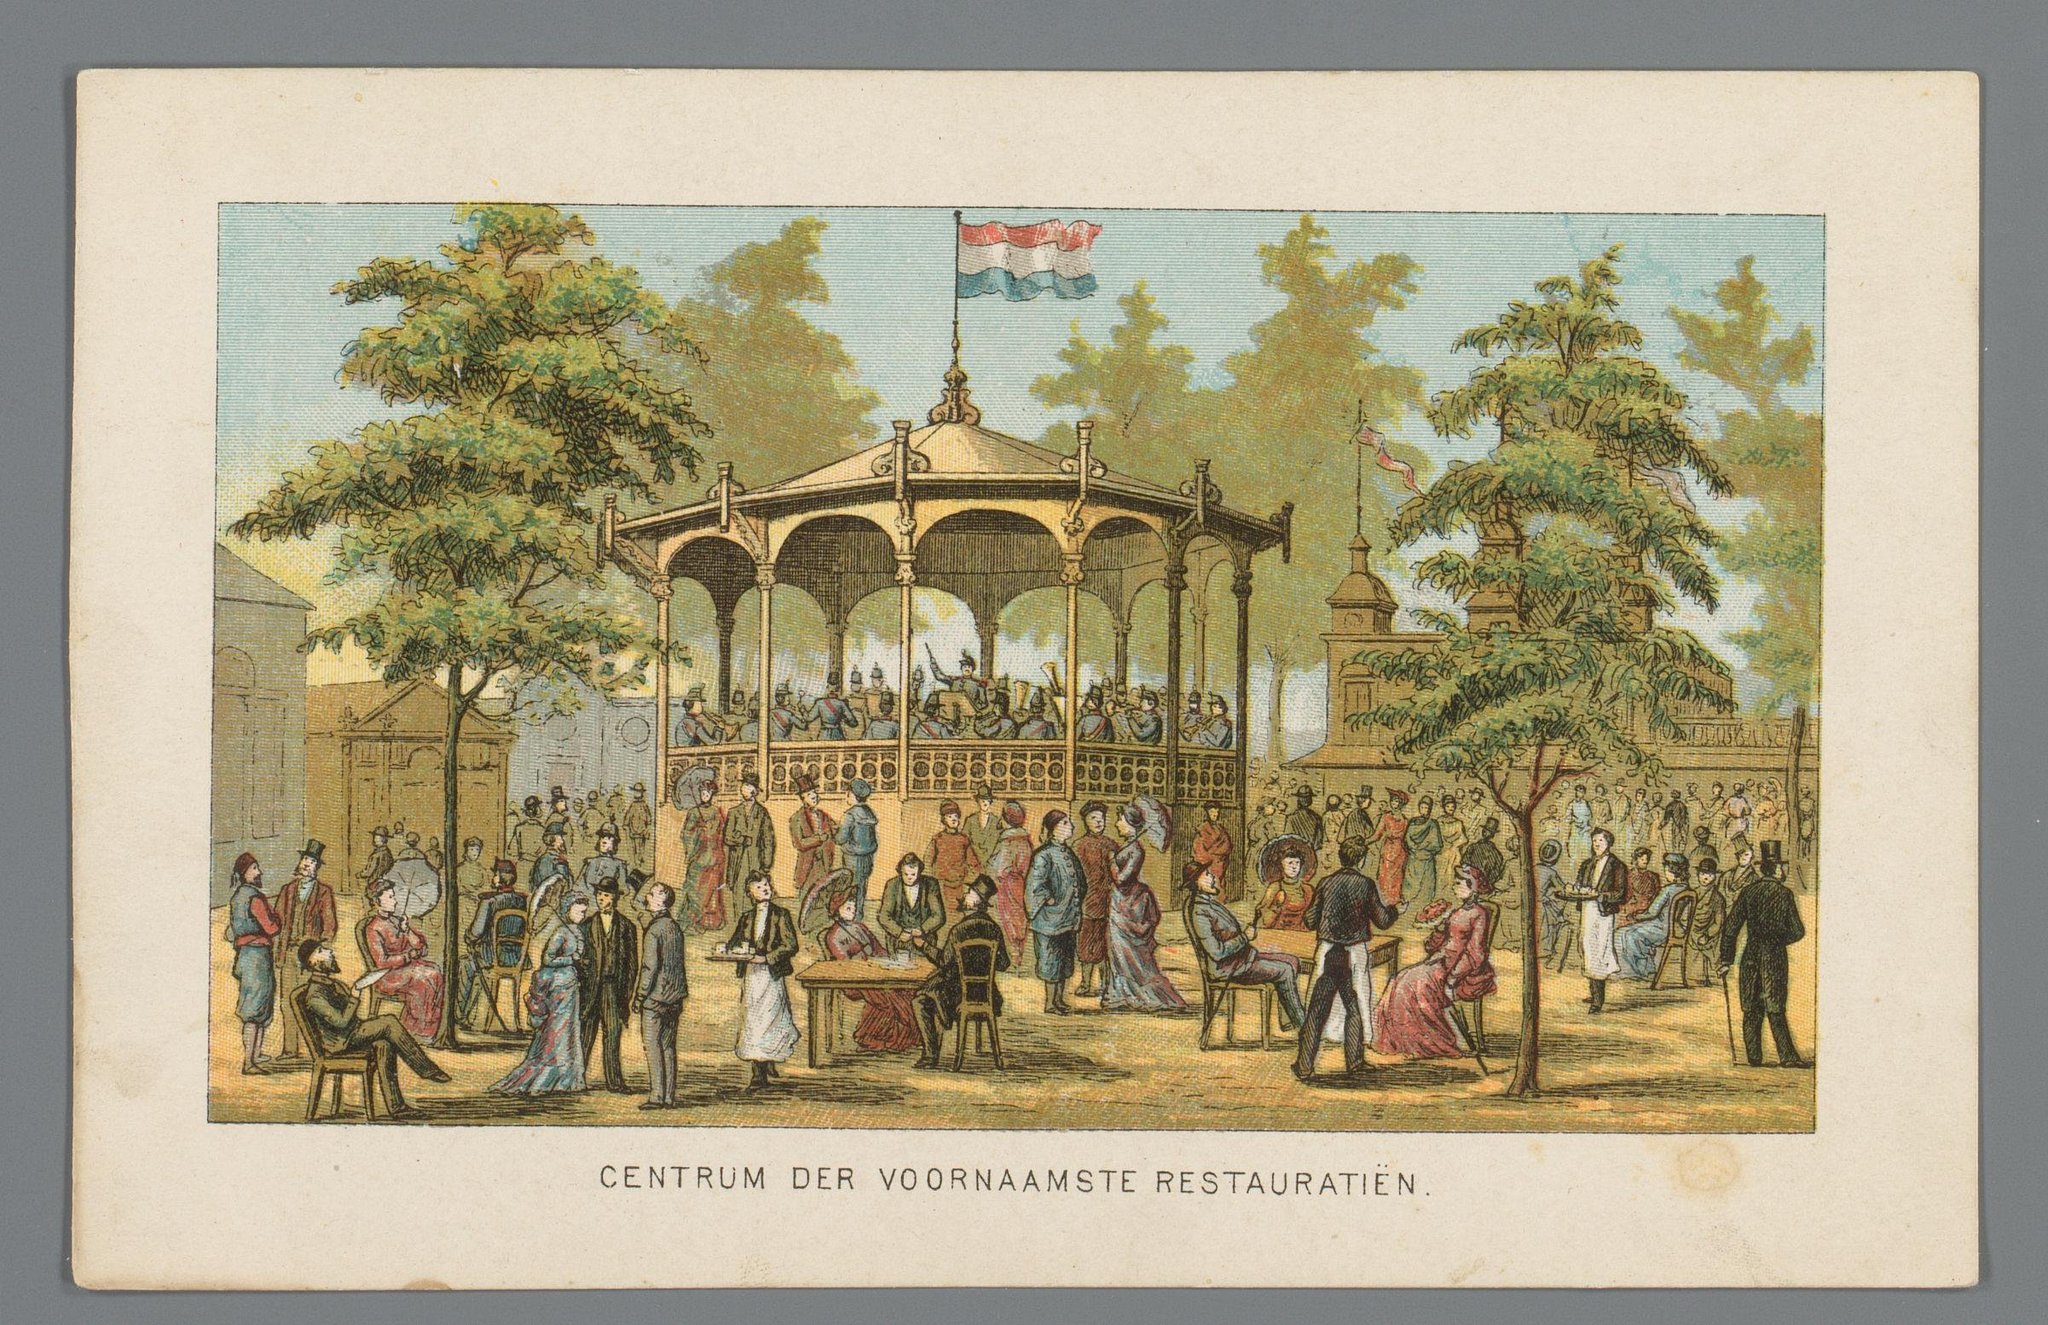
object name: print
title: Herinnering aan Amsterdam in 1883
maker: Anonymous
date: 1883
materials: paper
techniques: chromolithography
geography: amsterdam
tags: world fair, world exhibition, amsterdam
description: Deze prent komt voor in: Herinnering aan Amsterdam in 1883. Amsterdam: Het Nieuws van den Dag, 1883. Dit is een serie van zestien prenten over de wereldtentoonstelling in Amsterdam, 1883, met daarbij een plattegrond van het tentoonstellingsterrein en een omslag.